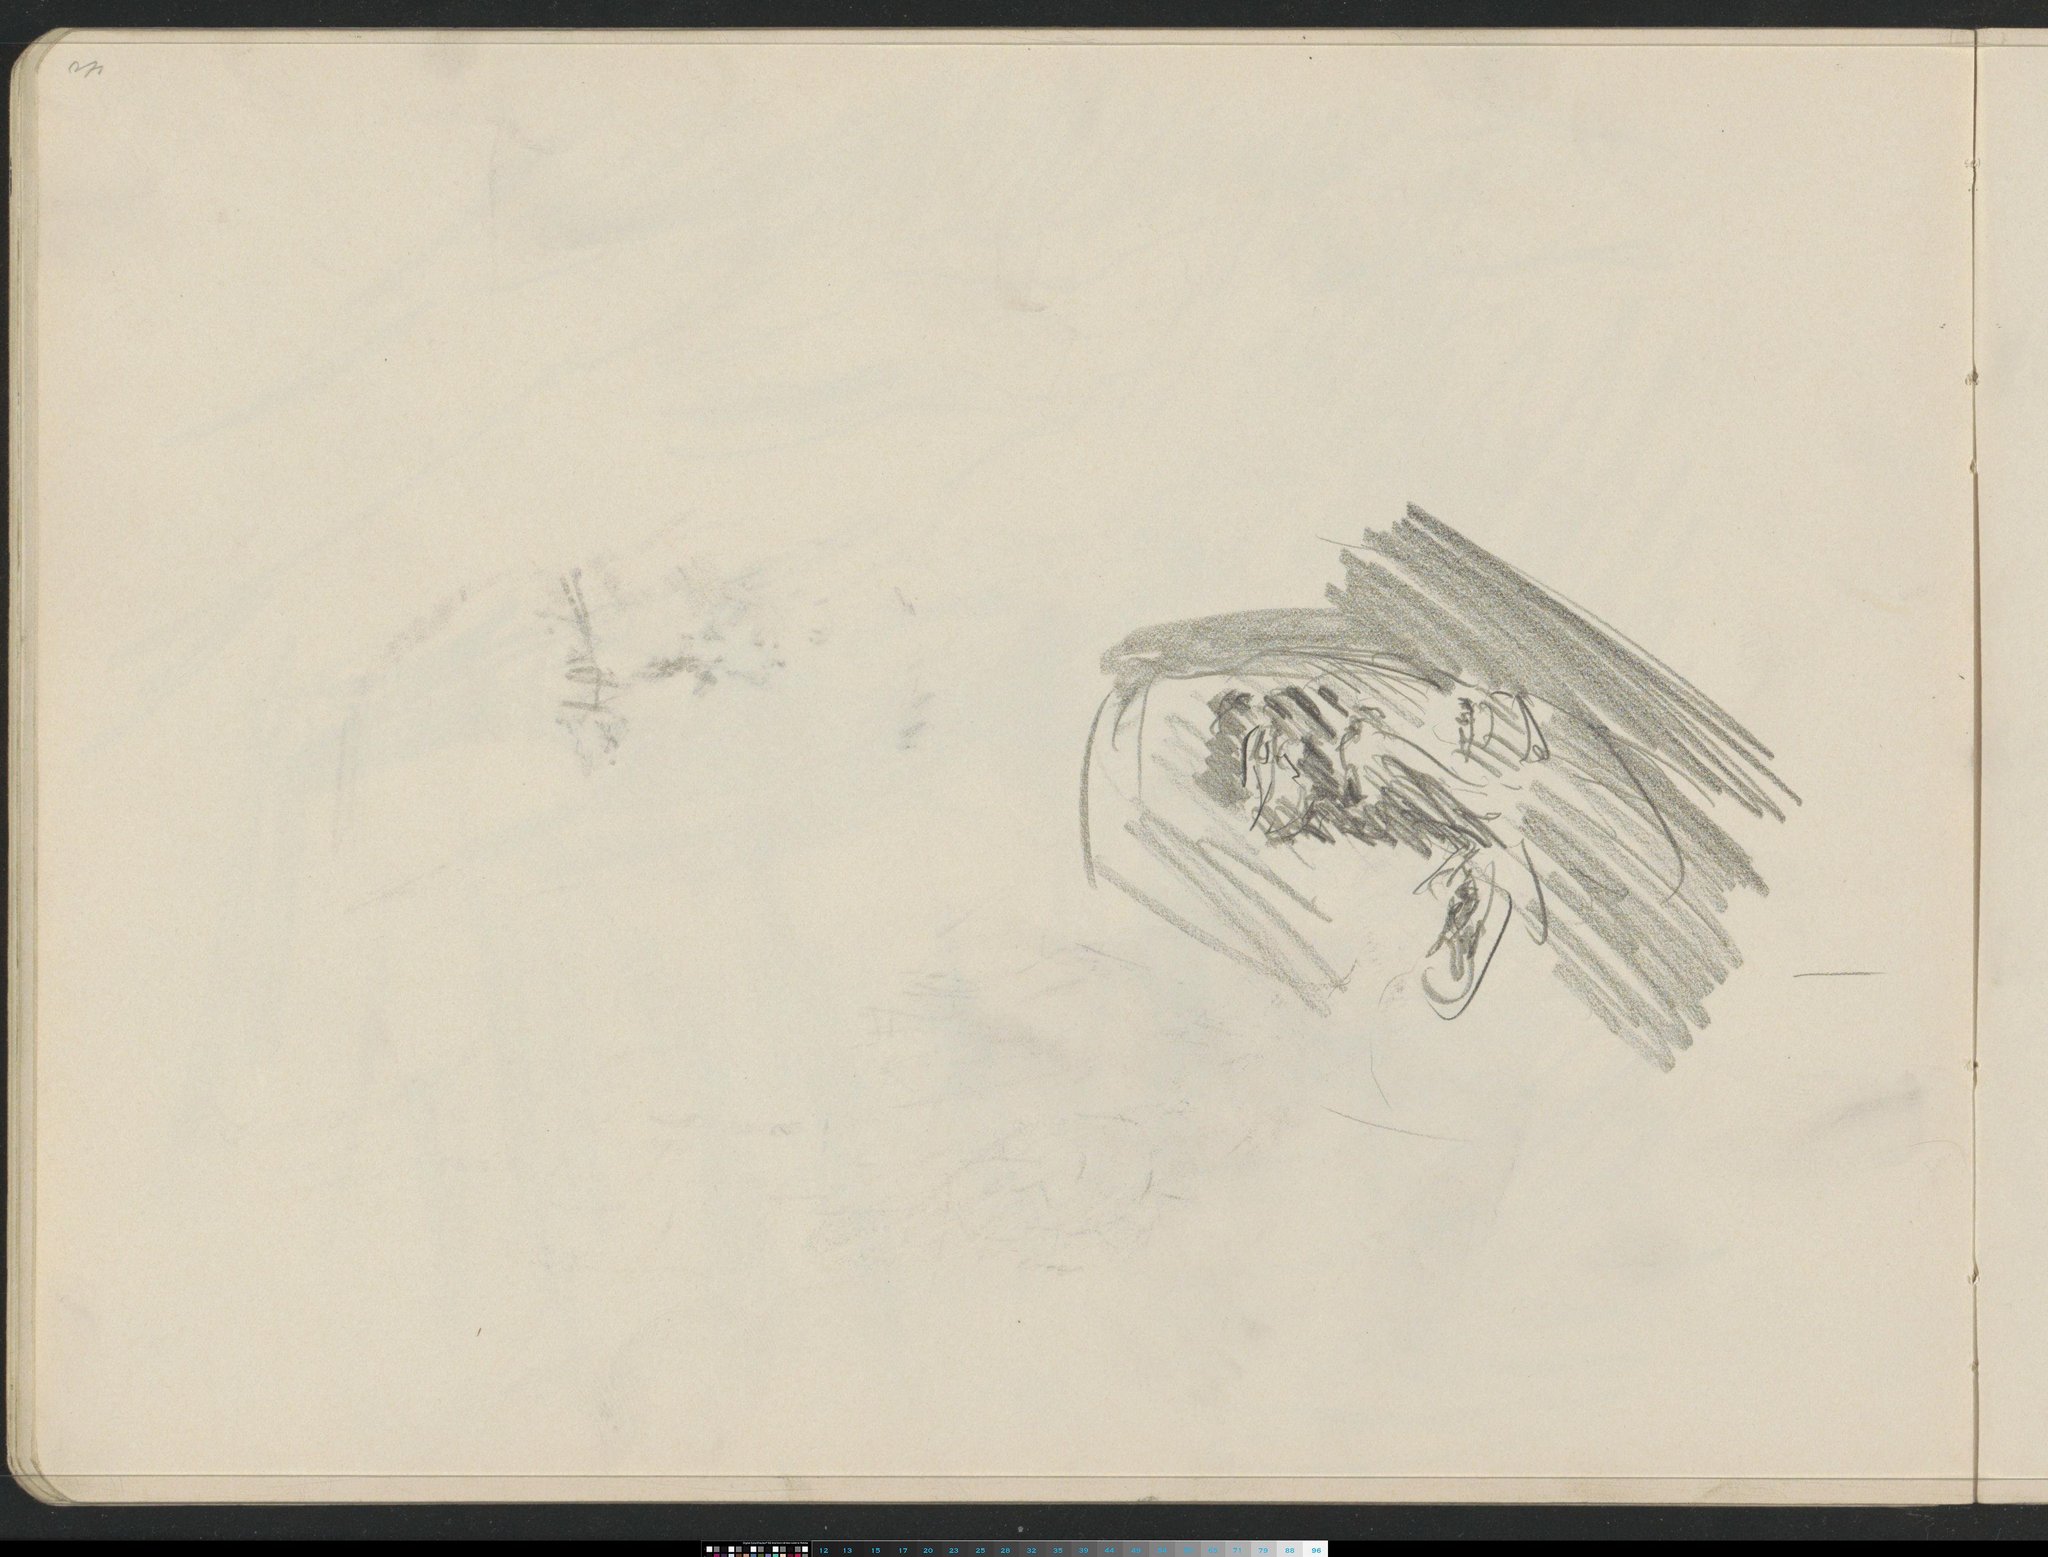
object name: sketchbook leaf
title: Gezicht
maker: isaac israels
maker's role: draughtsman, painter, print maker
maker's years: 1865-1934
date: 1915-1934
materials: paper, pencil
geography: the hague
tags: face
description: Blad 23 verso uit schetsboek XVII met 31 bladen.